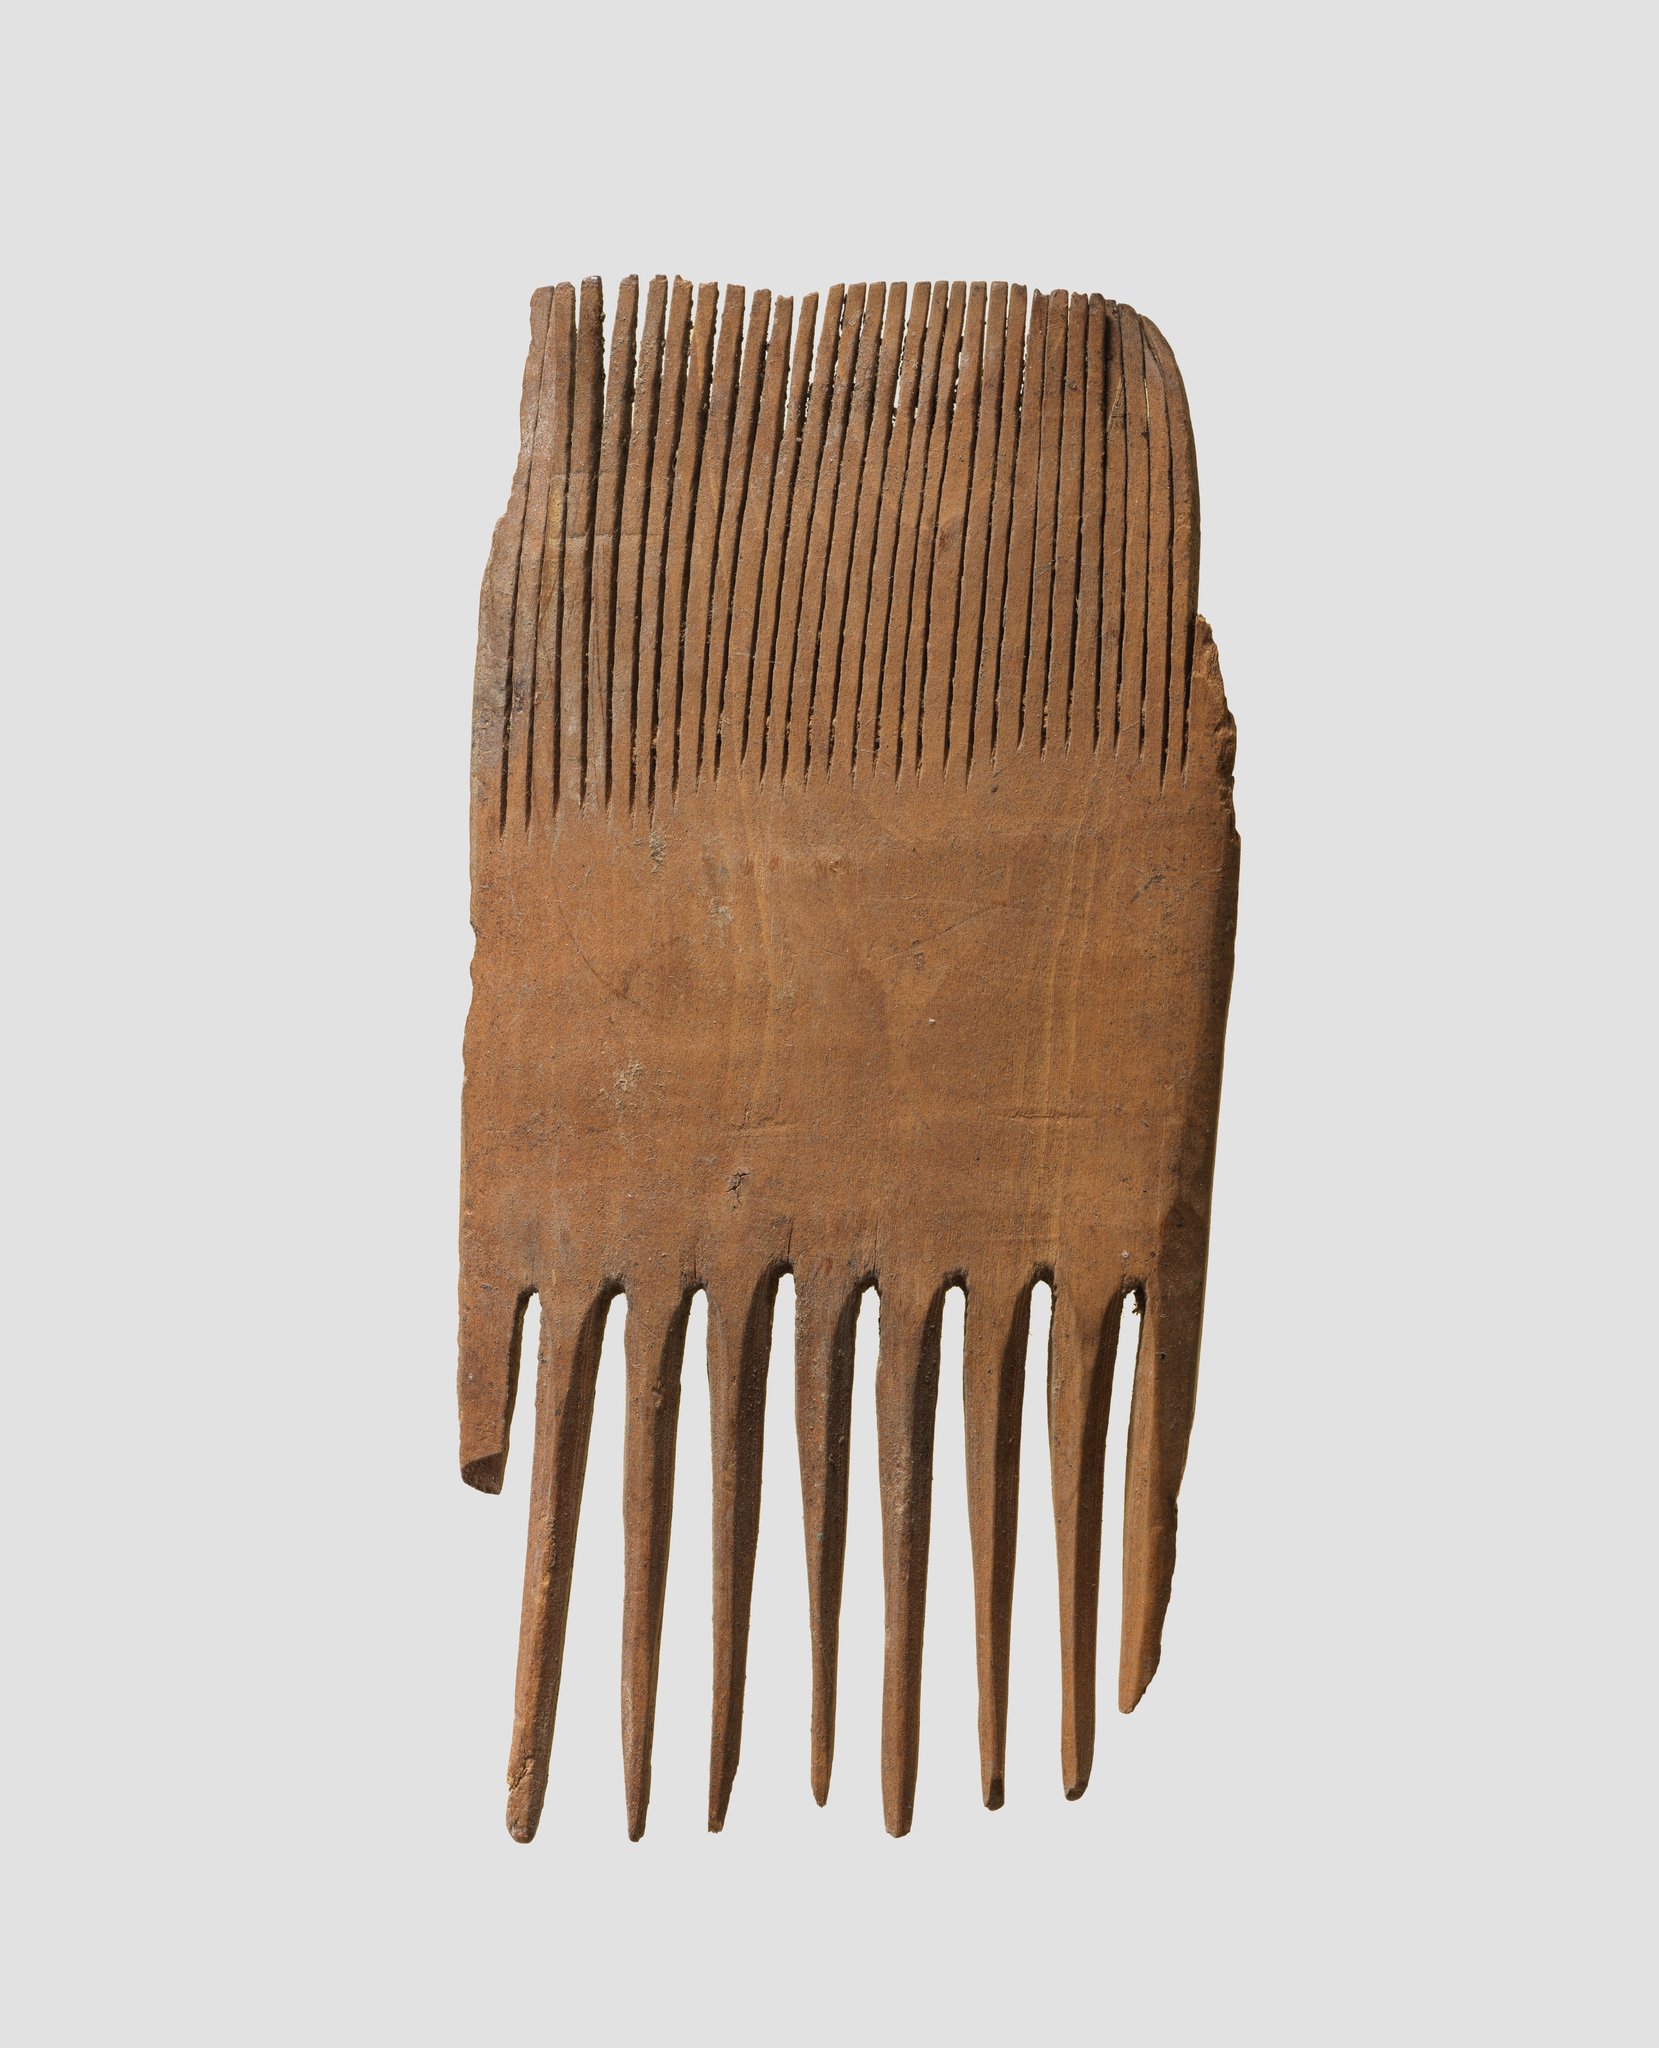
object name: comb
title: Double-sided wooden comb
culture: alanic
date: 601-900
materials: wood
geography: caucasus